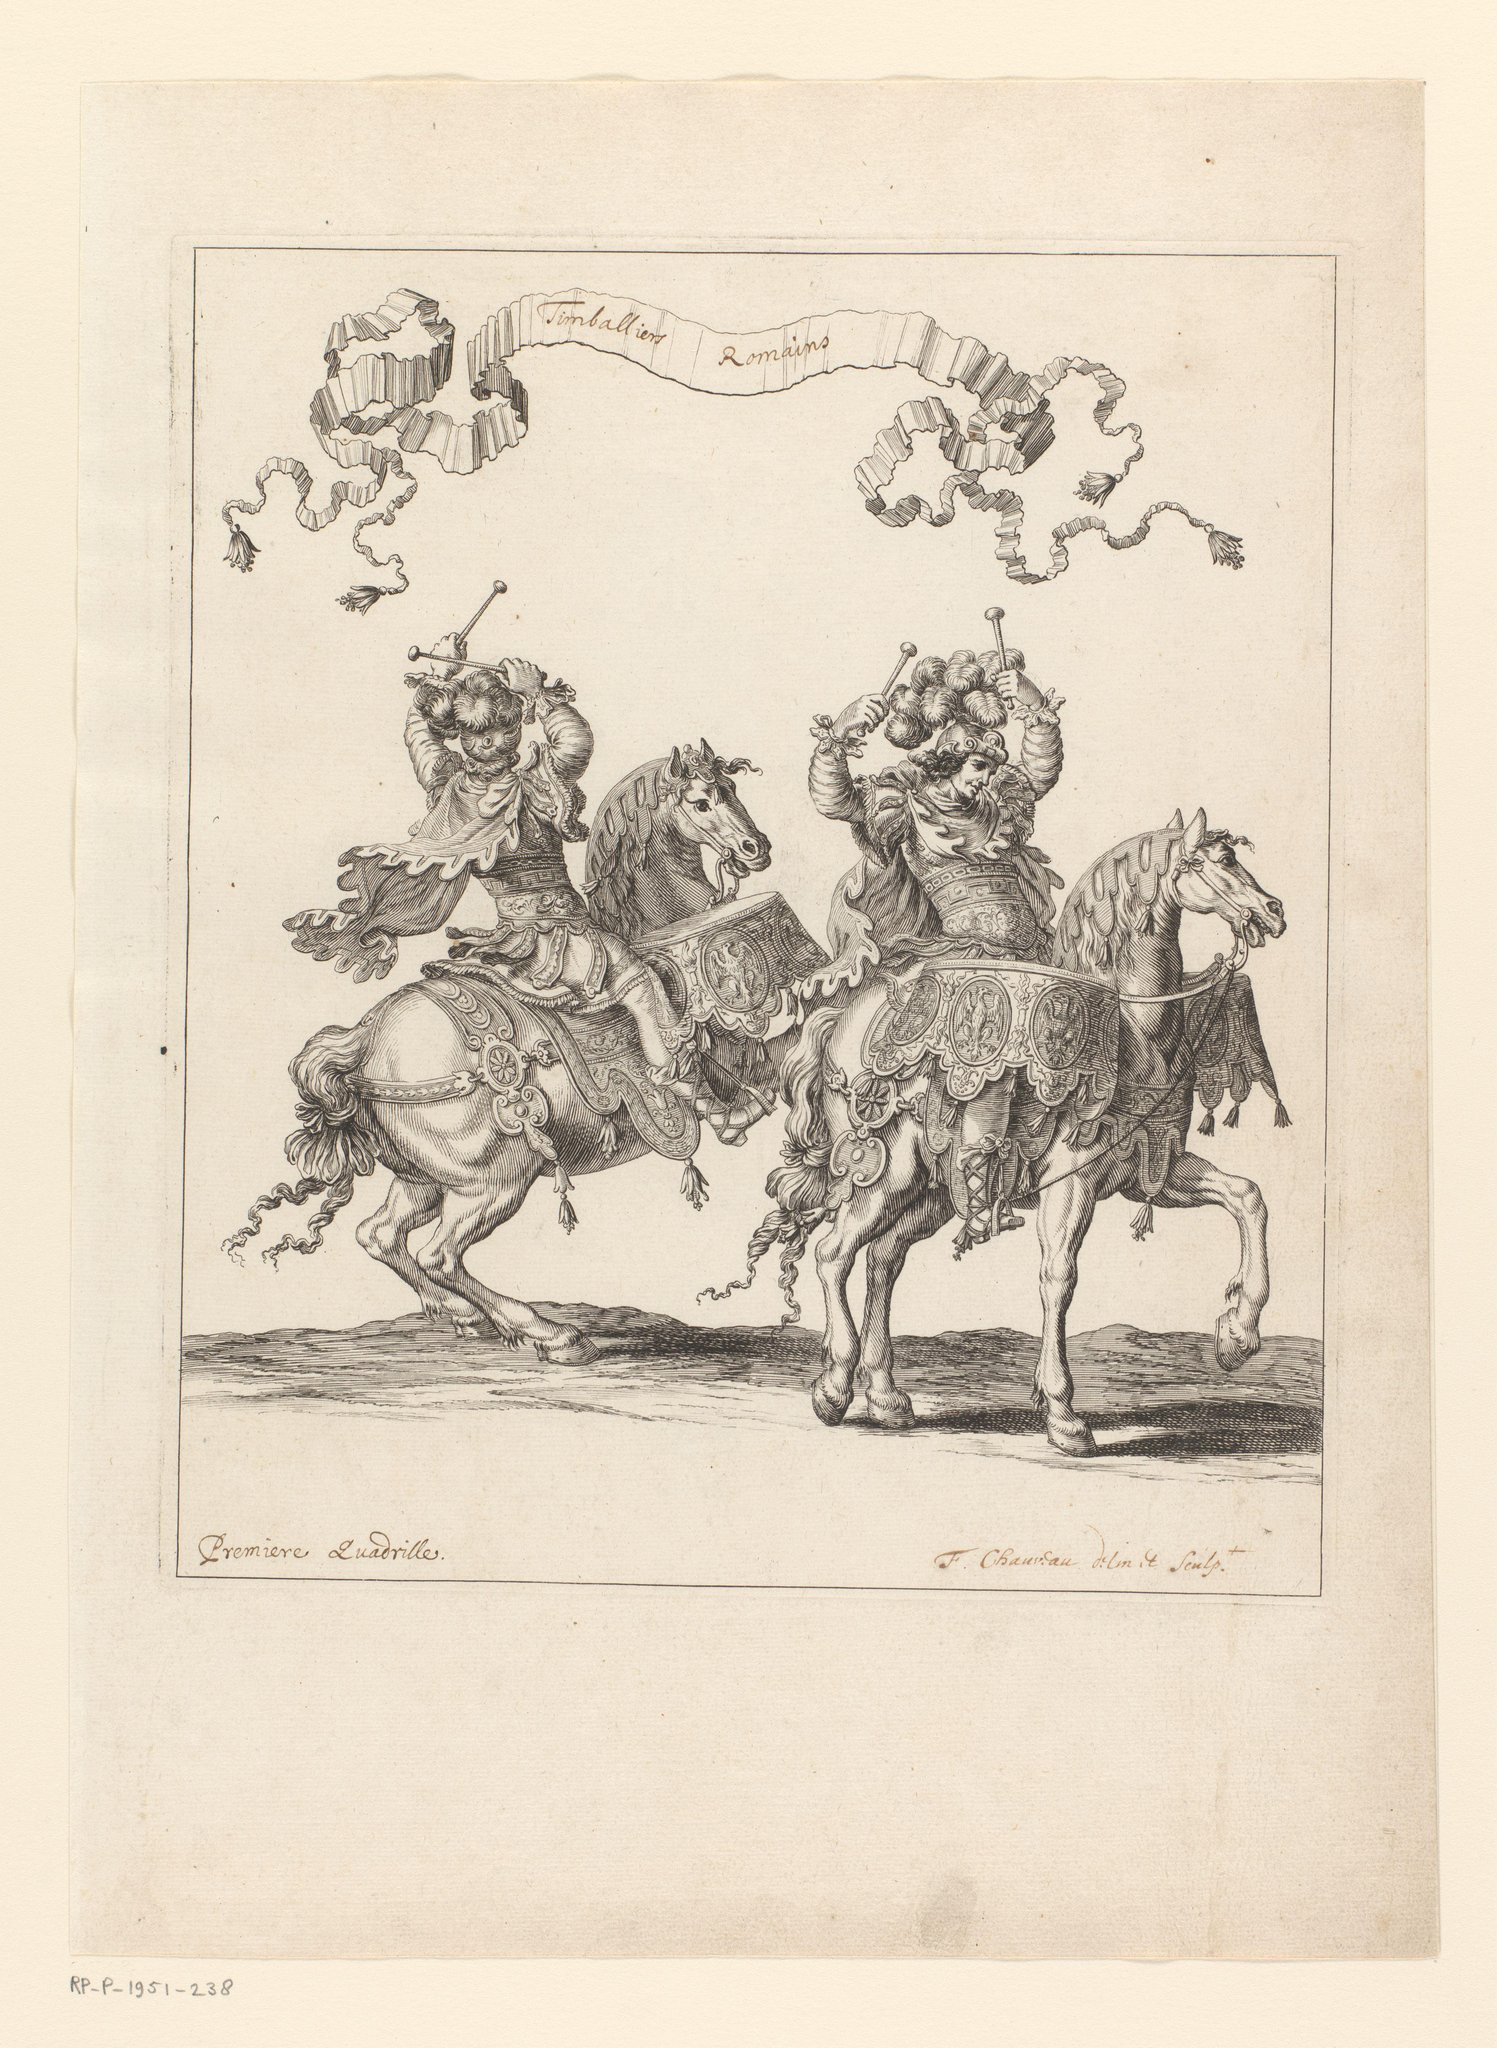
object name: print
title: Timballiers Romains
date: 1670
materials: paper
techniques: etching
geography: france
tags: tournament, drum-head court-martial, horse, festivities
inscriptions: inscription, collector's mark: Lugt 2228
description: Prent uit: Perrault, Charles. Courses de testes et de bague faites par le Roy et par les princes et seigneurs de sa cour en l'année M.DC.LXII. Parijs: Imprimerie Royale, 1670. De prenten illustreren de door Lodewijk XIV georganiseerde festiviteiten in juni 1662 te Tuileries, zoals steekspelen met figuren in verschillende kostuums.